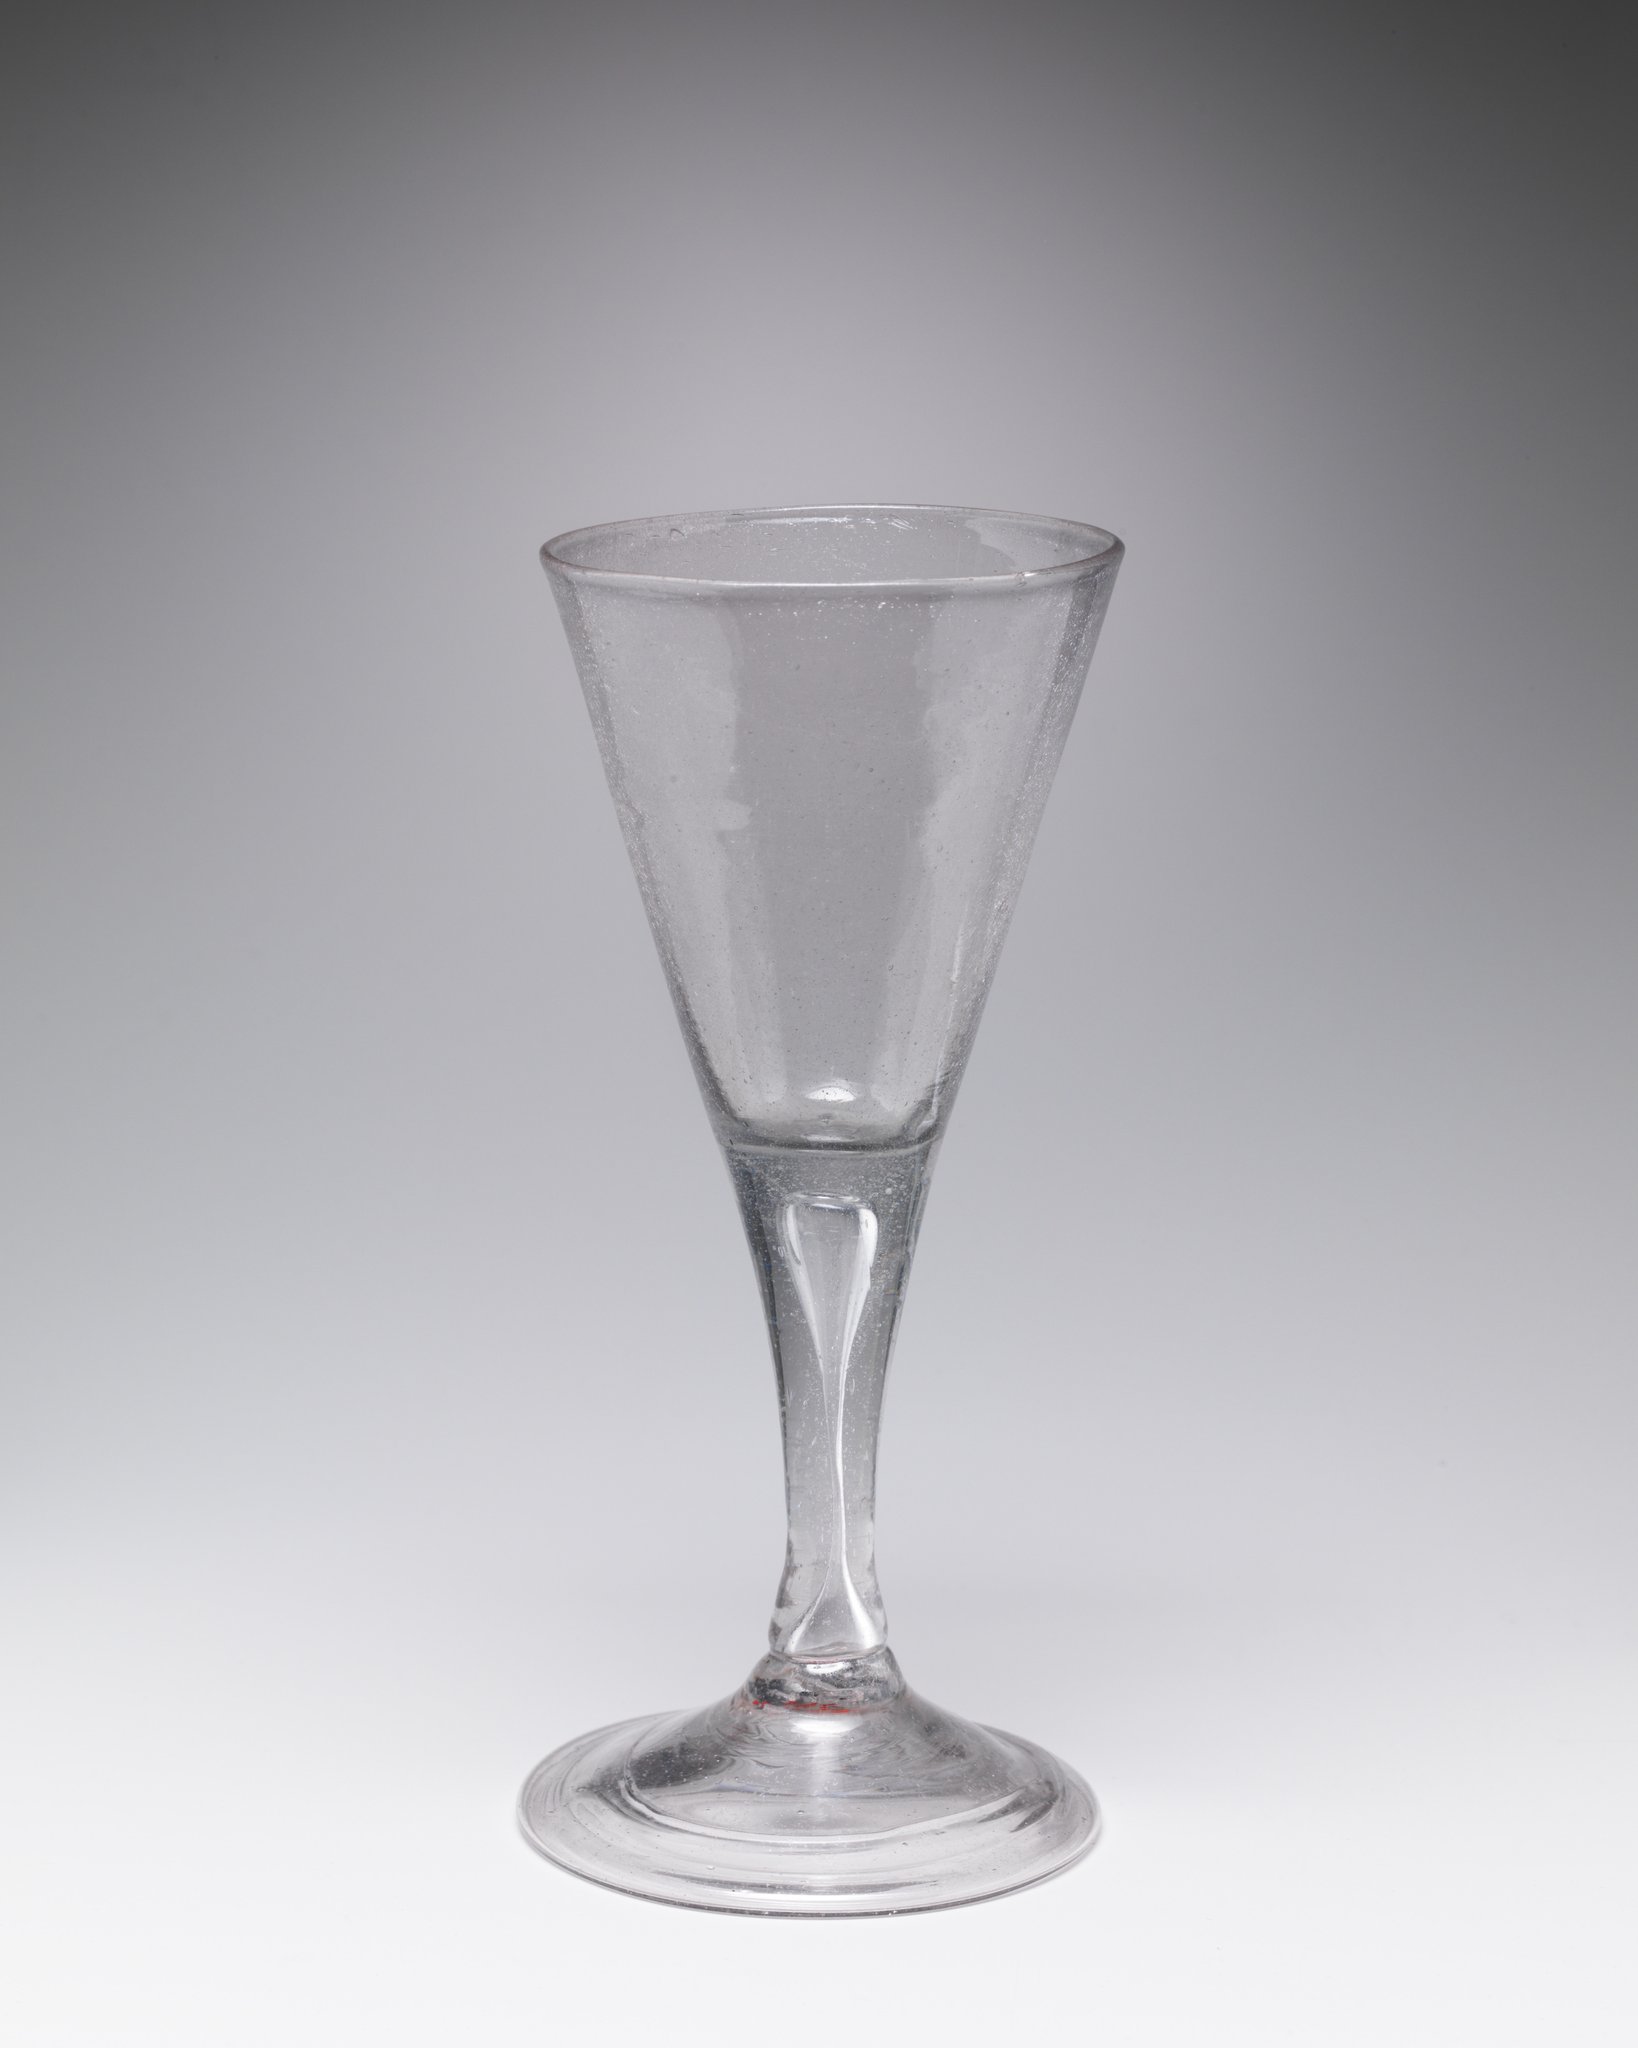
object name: wineglass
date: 1701-1800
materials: glass